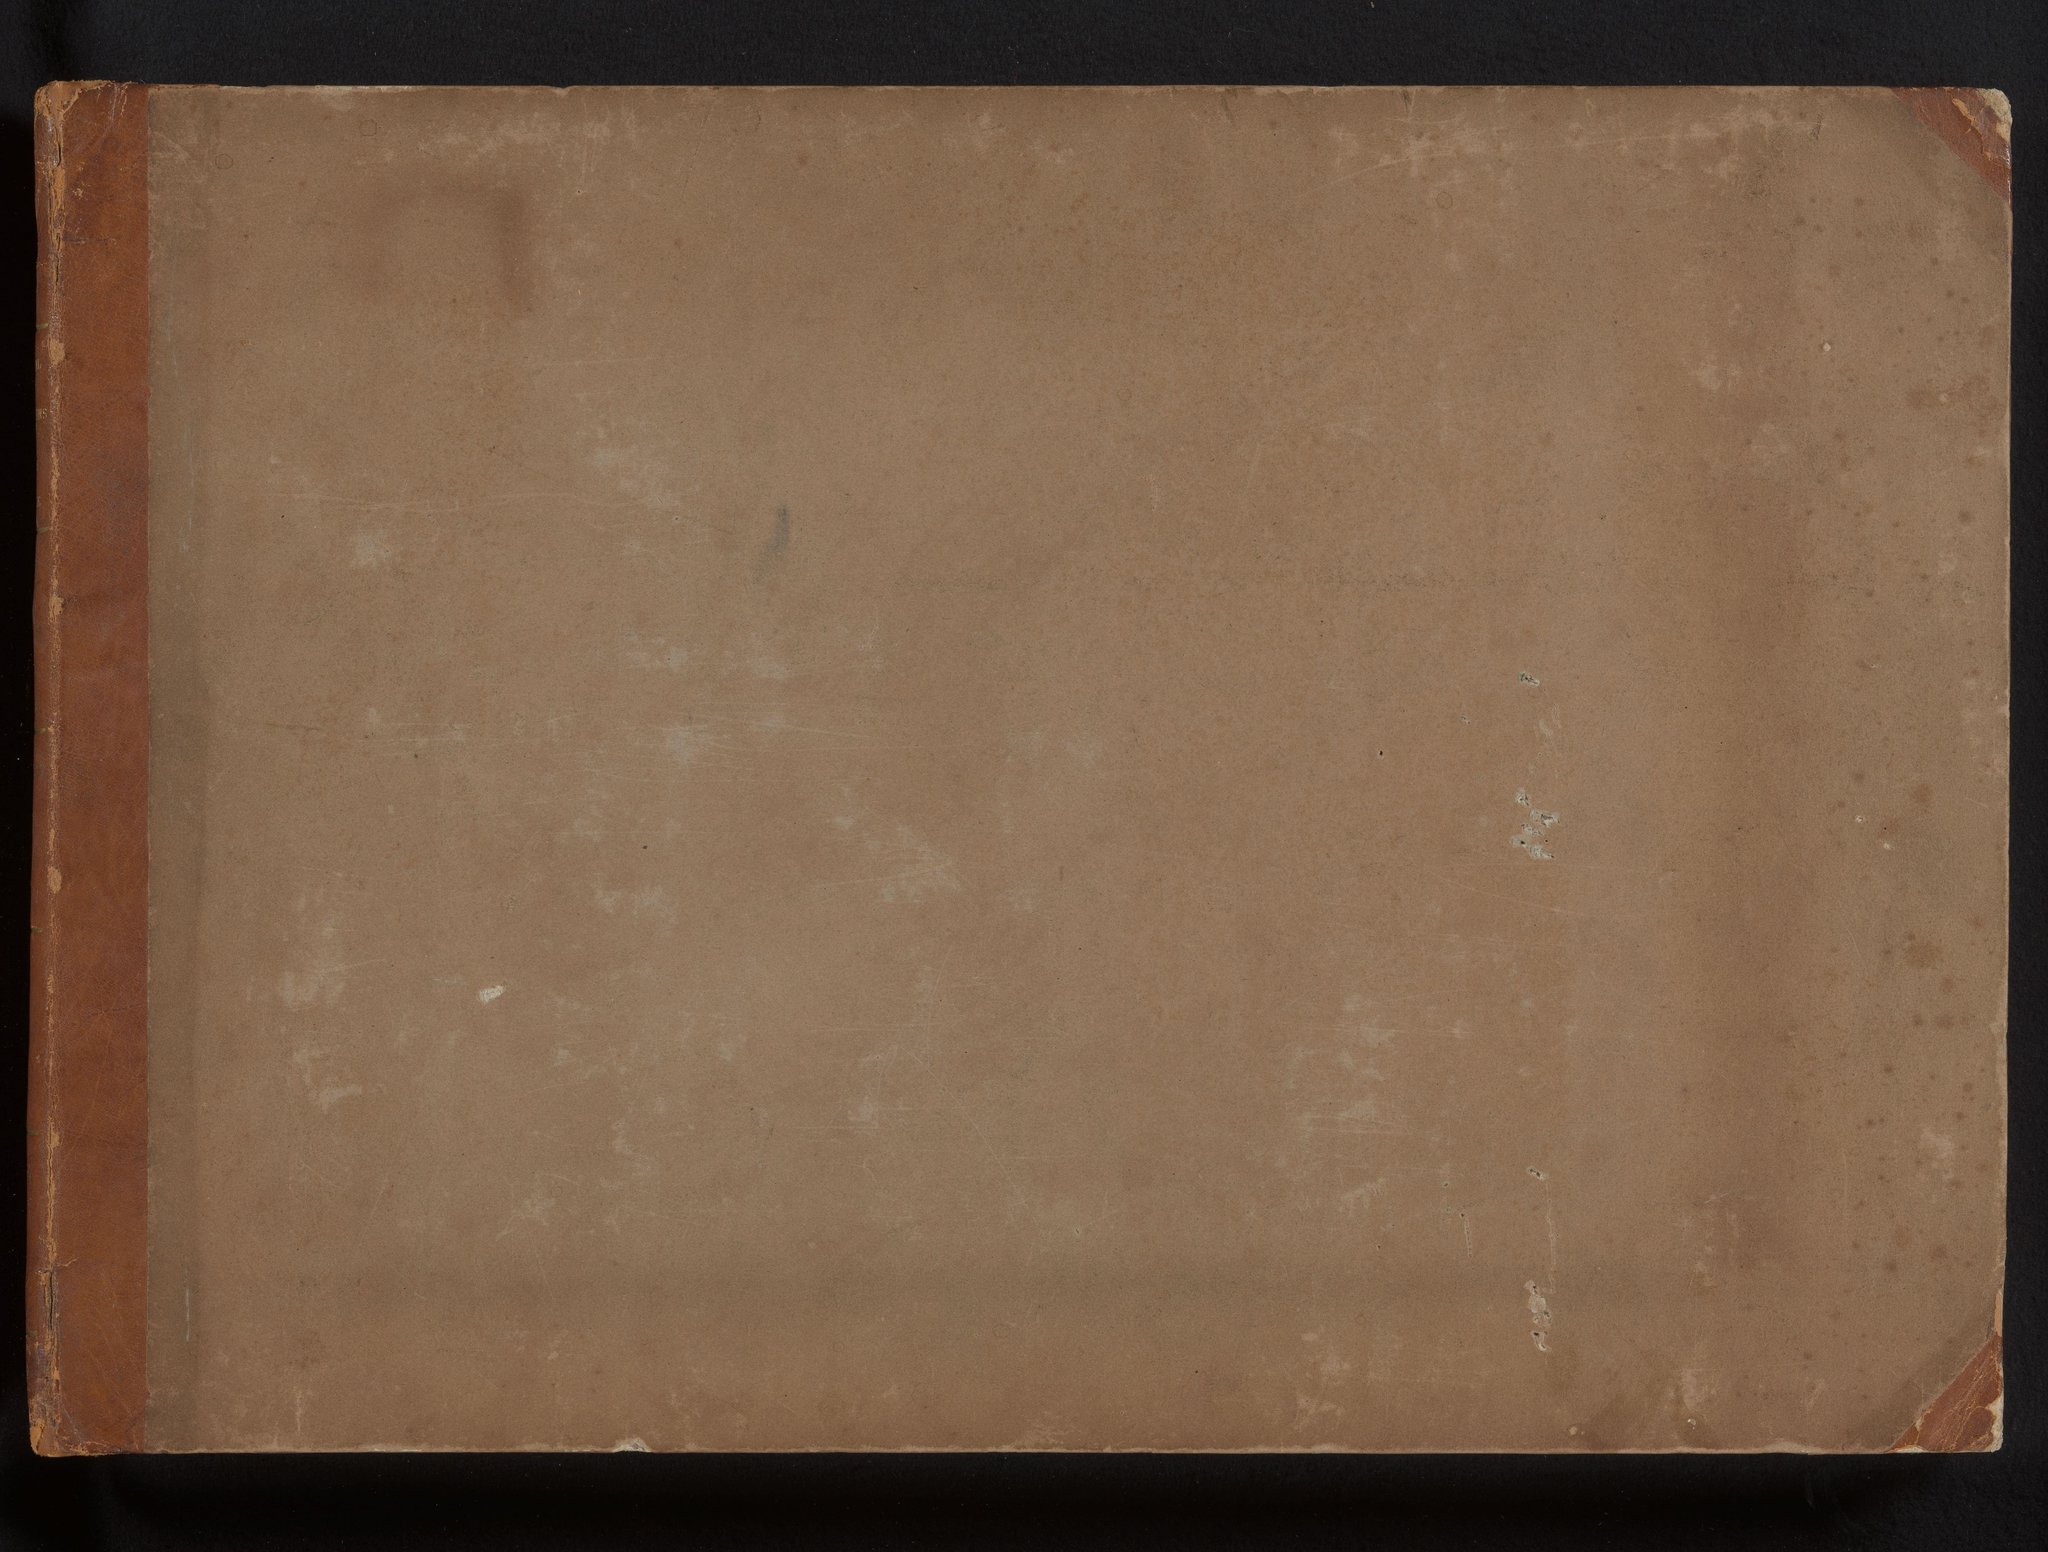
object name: prentrecueil, prentenalbum, prentalbum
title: Serie lithografieën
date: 1818-1819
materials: cardboard, paper, leather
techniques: bookbinding, lithograph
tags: landscapes, monks and nuns, warfare; military affairs, horse, herd, flock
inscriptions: collector's mark: Lugt 2760, bookplate: ‘Bibliothèque de M. Le Duc d'Uzès Château de Bonnelles’, collector's mark: Lugt 2228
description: Album met vijftig litho's op vijftig albumbladen uit de beginperiode van de lithografie.